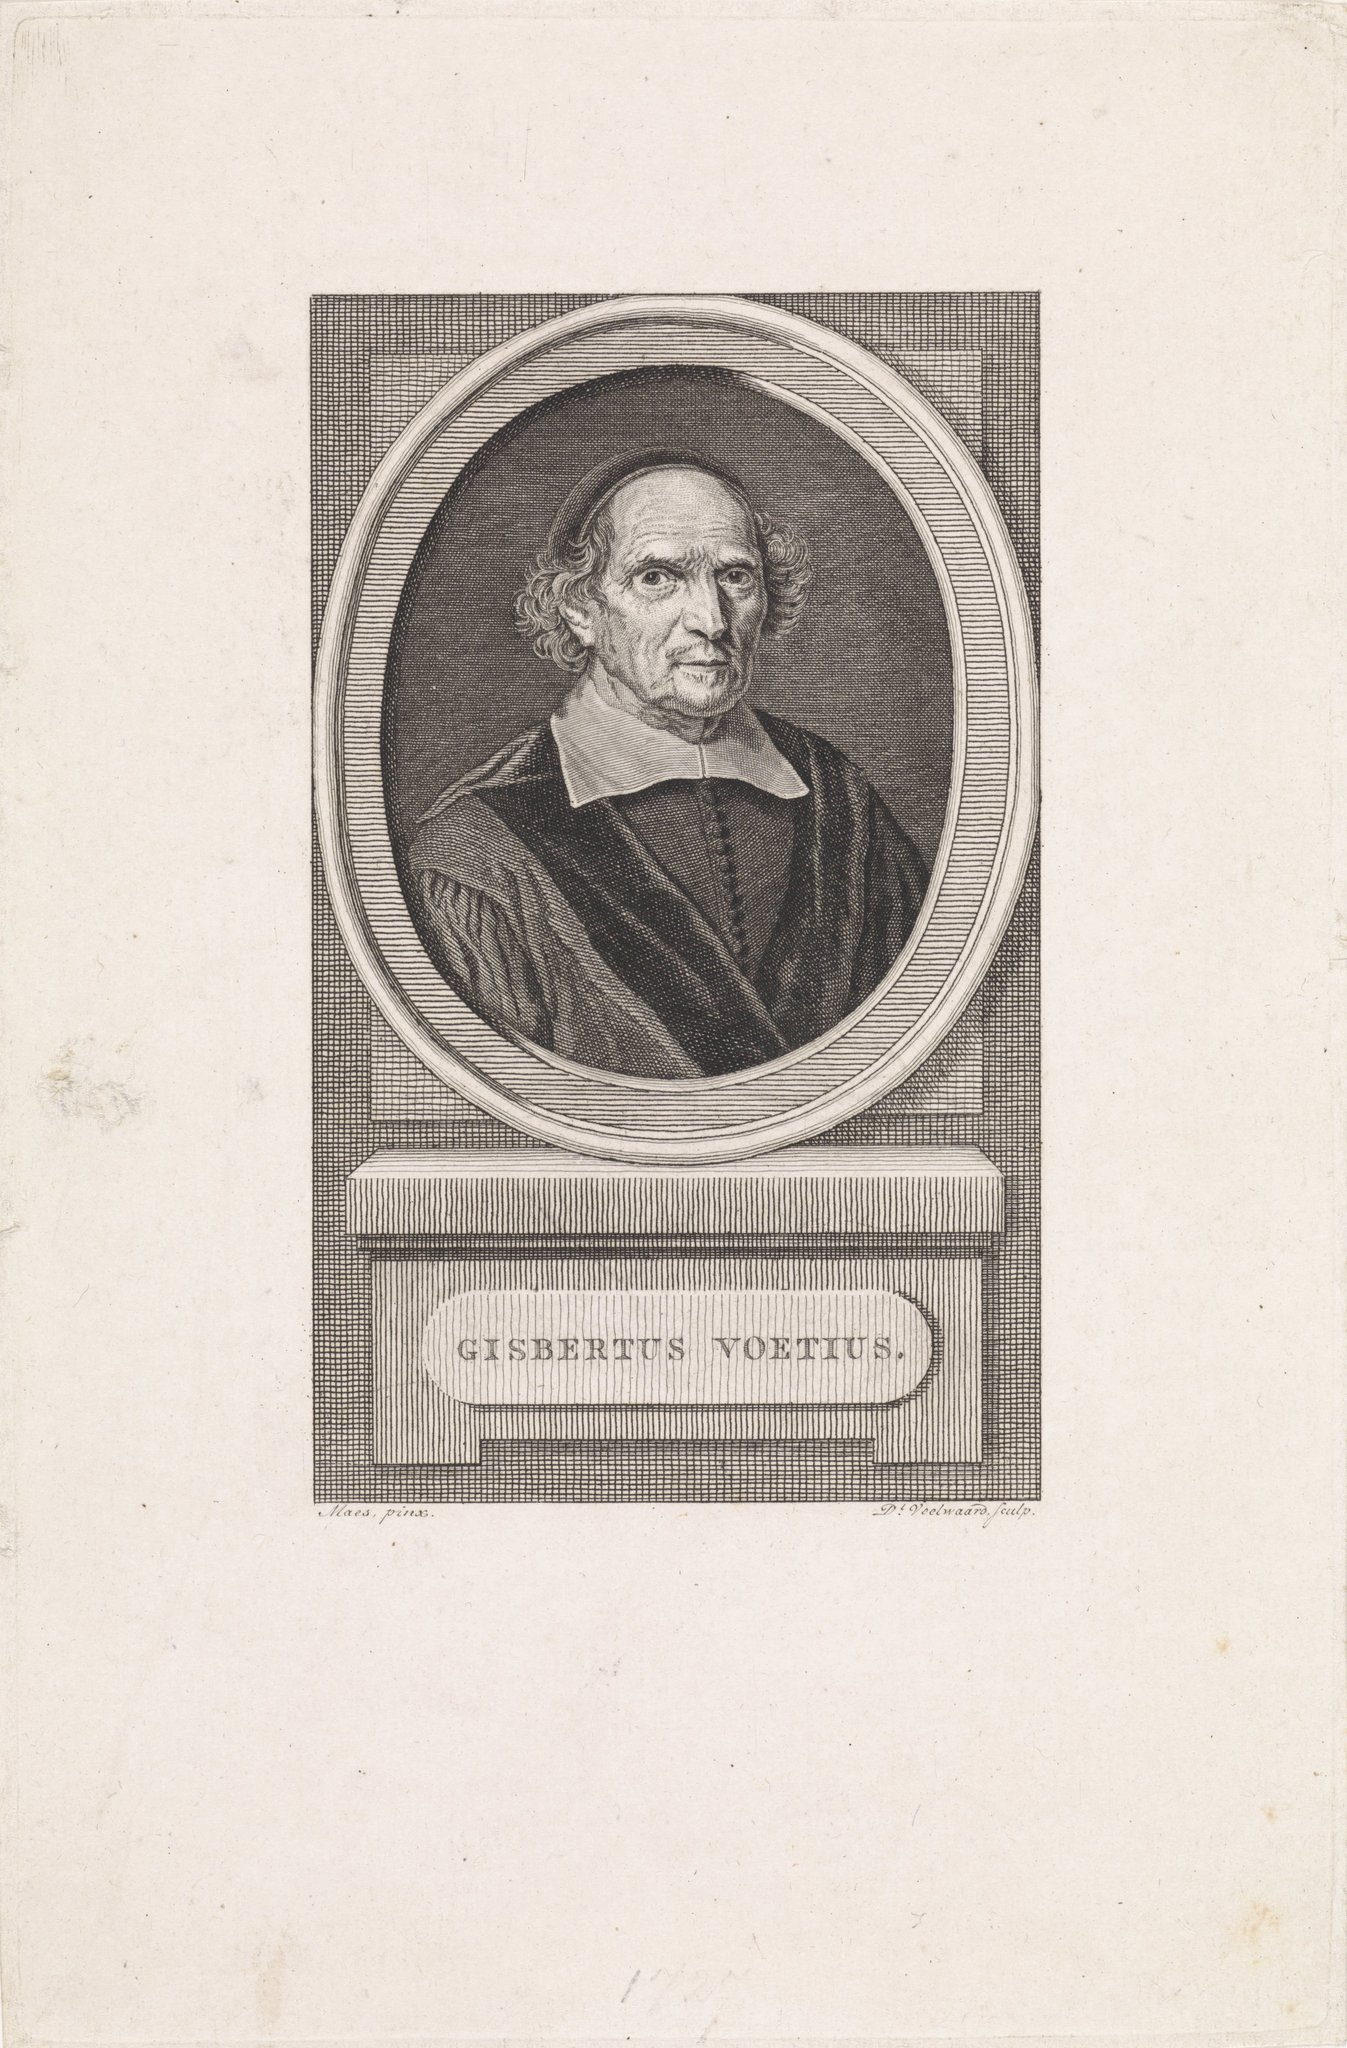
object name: print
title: Portret van de theoloog Gisbertus Voetius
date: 1776-1851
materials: paper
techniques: engraving, etching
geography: amsterdam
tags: utrecht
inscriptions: number: ‘-20’, collector's mark: Lugt 2228